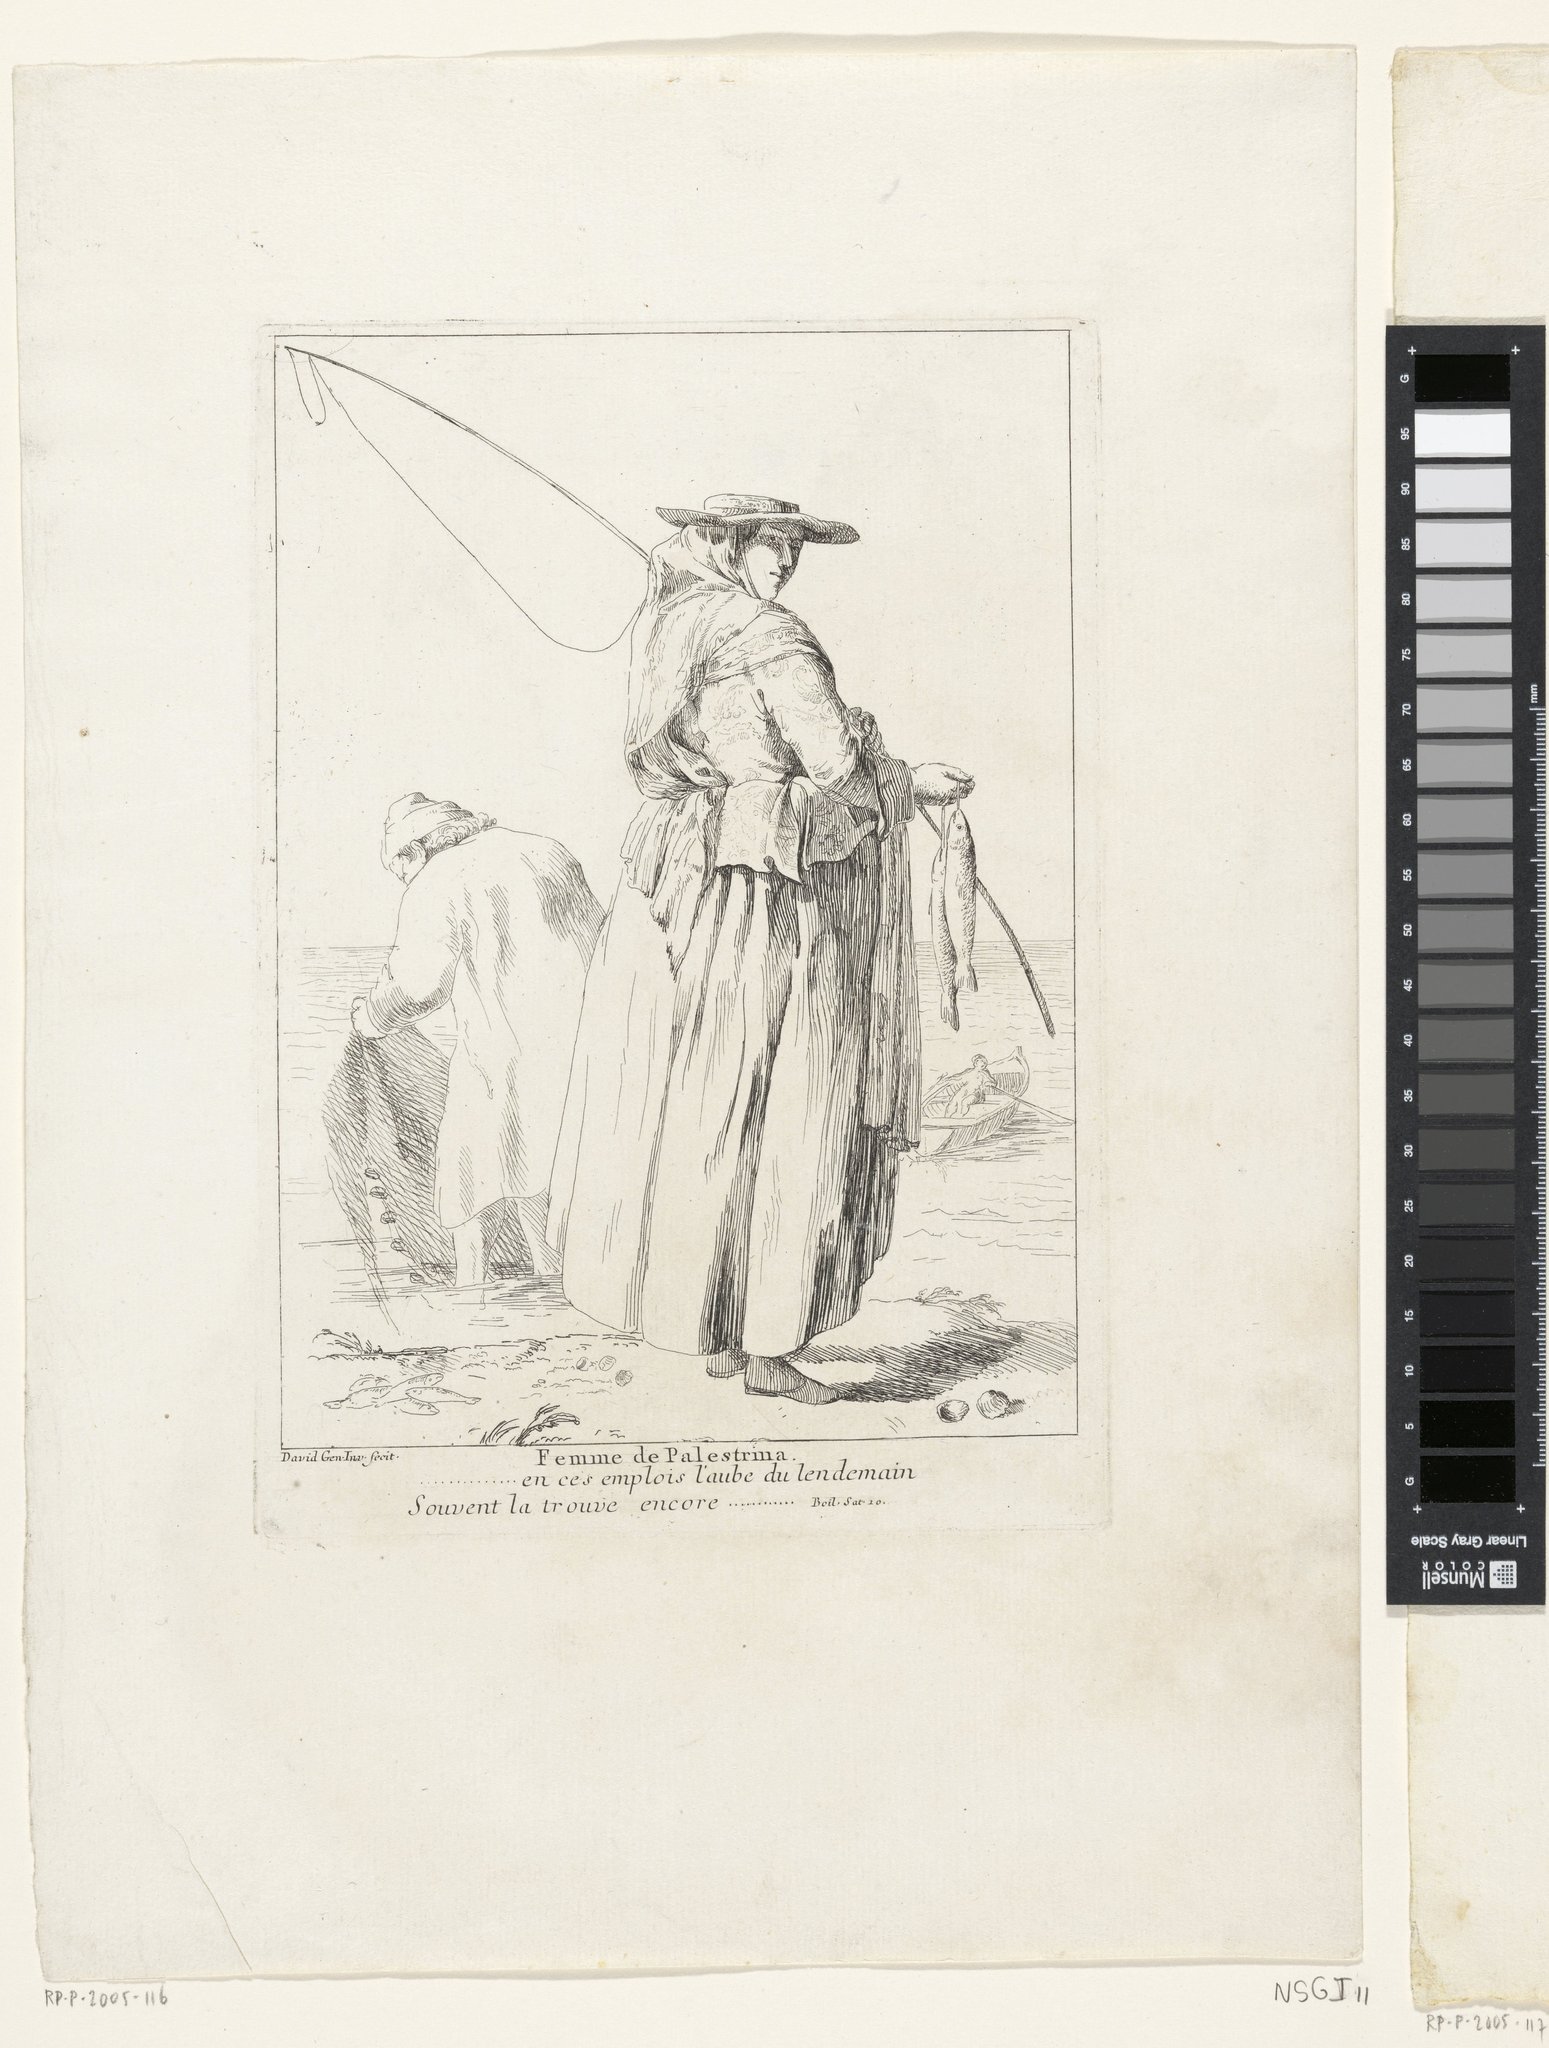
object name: print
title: Divers portraits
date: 1775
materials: paper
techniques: etching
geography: venice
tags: fishing net, folk costume, regional costume, fisherman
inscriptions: collector's mark: Lugt 2760, collector's mark: Lugt 2228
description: Een vissersvrouw staand aan de kust met een hengel en vissen in haar handen. Achter haar staat een visser met een net. Titel in ondermarge.